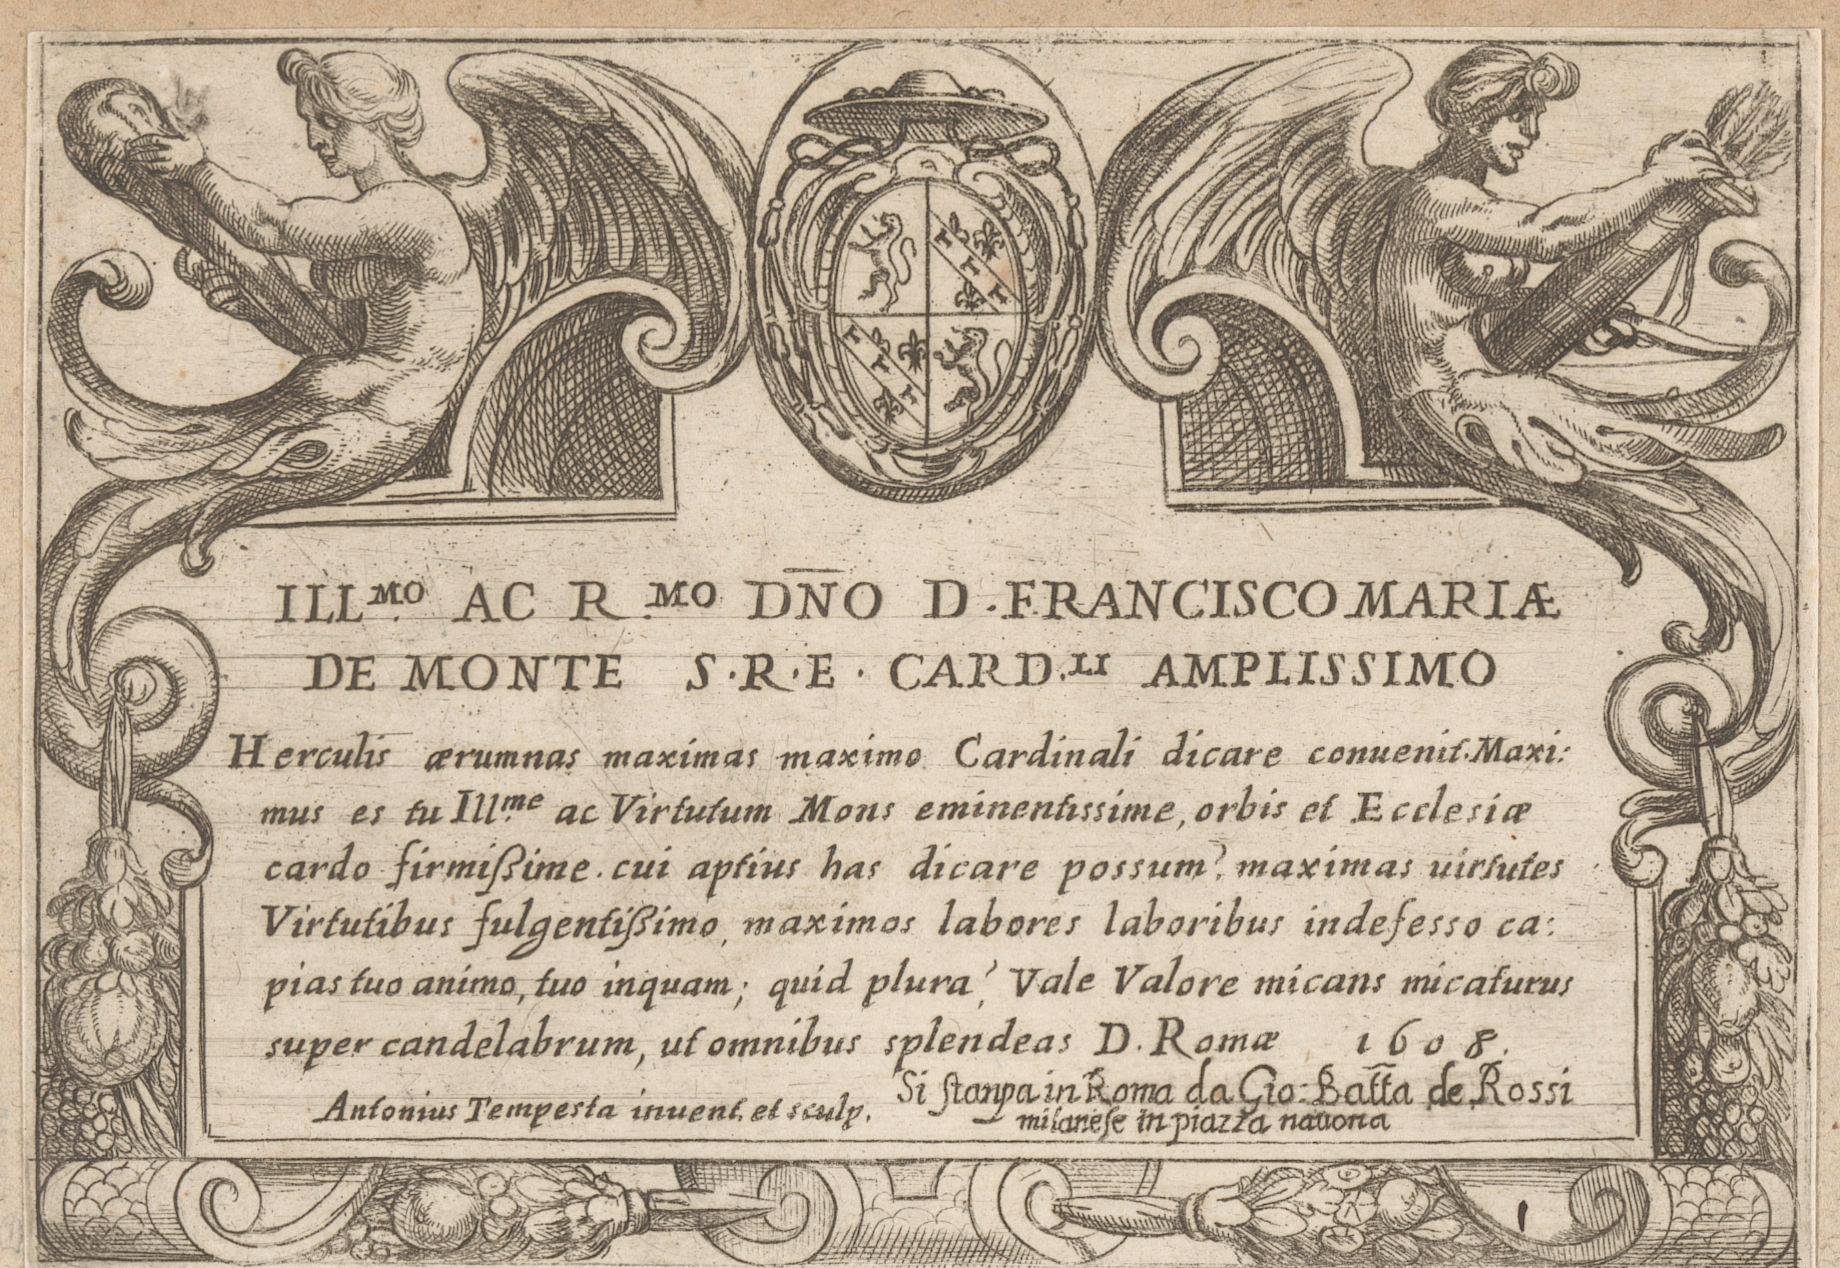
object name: print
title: Cartouche met gevleugelde figuren, guirlandes en opdracht aan kardinaal Bourbon del Monte Santa Maria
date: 1608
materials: paper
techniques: etching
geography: rome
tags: ornament ~ cartouche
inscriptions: number: ‘1’, collector's mark: ‘Hinloopen’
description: Opdracht bij een reeks van 12 prenten met de twaalf werken van Hercules.